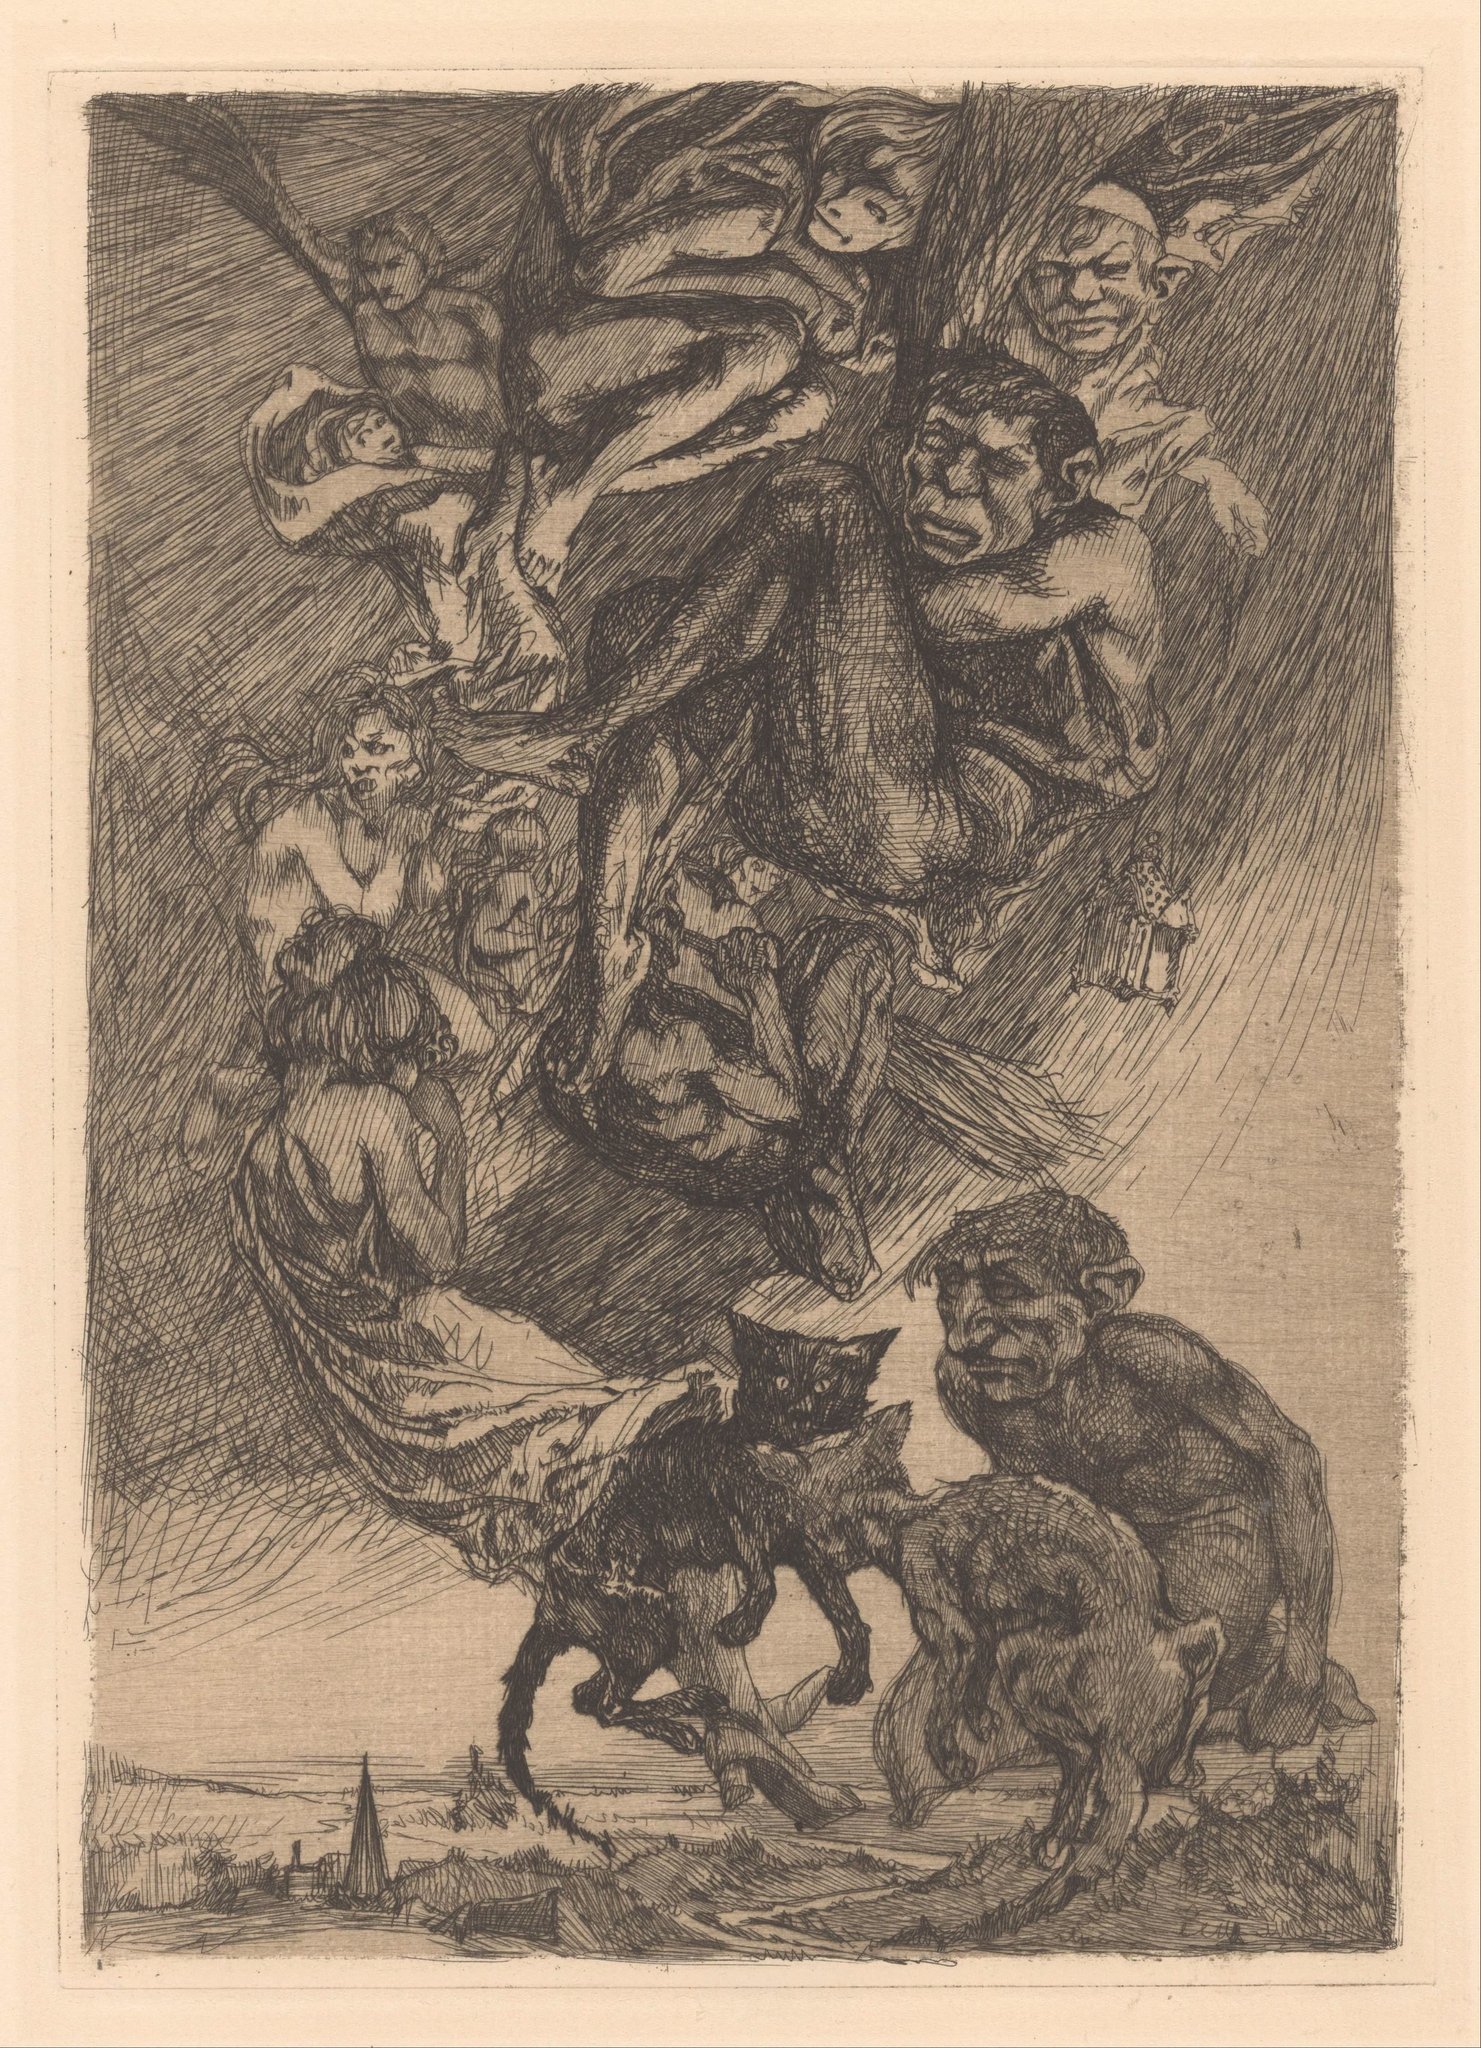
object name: print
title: Fantastische compositie met katten, monsters, etc.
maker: johannes josephus aarts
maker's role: draughtsman, print maker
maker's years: 1871-1934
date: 1881-1934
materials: paper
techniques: etching, intaglio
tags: movement in the air, cat, surrealia, surrealistic representations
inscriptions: collector's mark: Lugt 2228, collector's mark: Lugt 2166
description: Onder hen een vlak landschap met links bebouwing en in het midden een rivier.